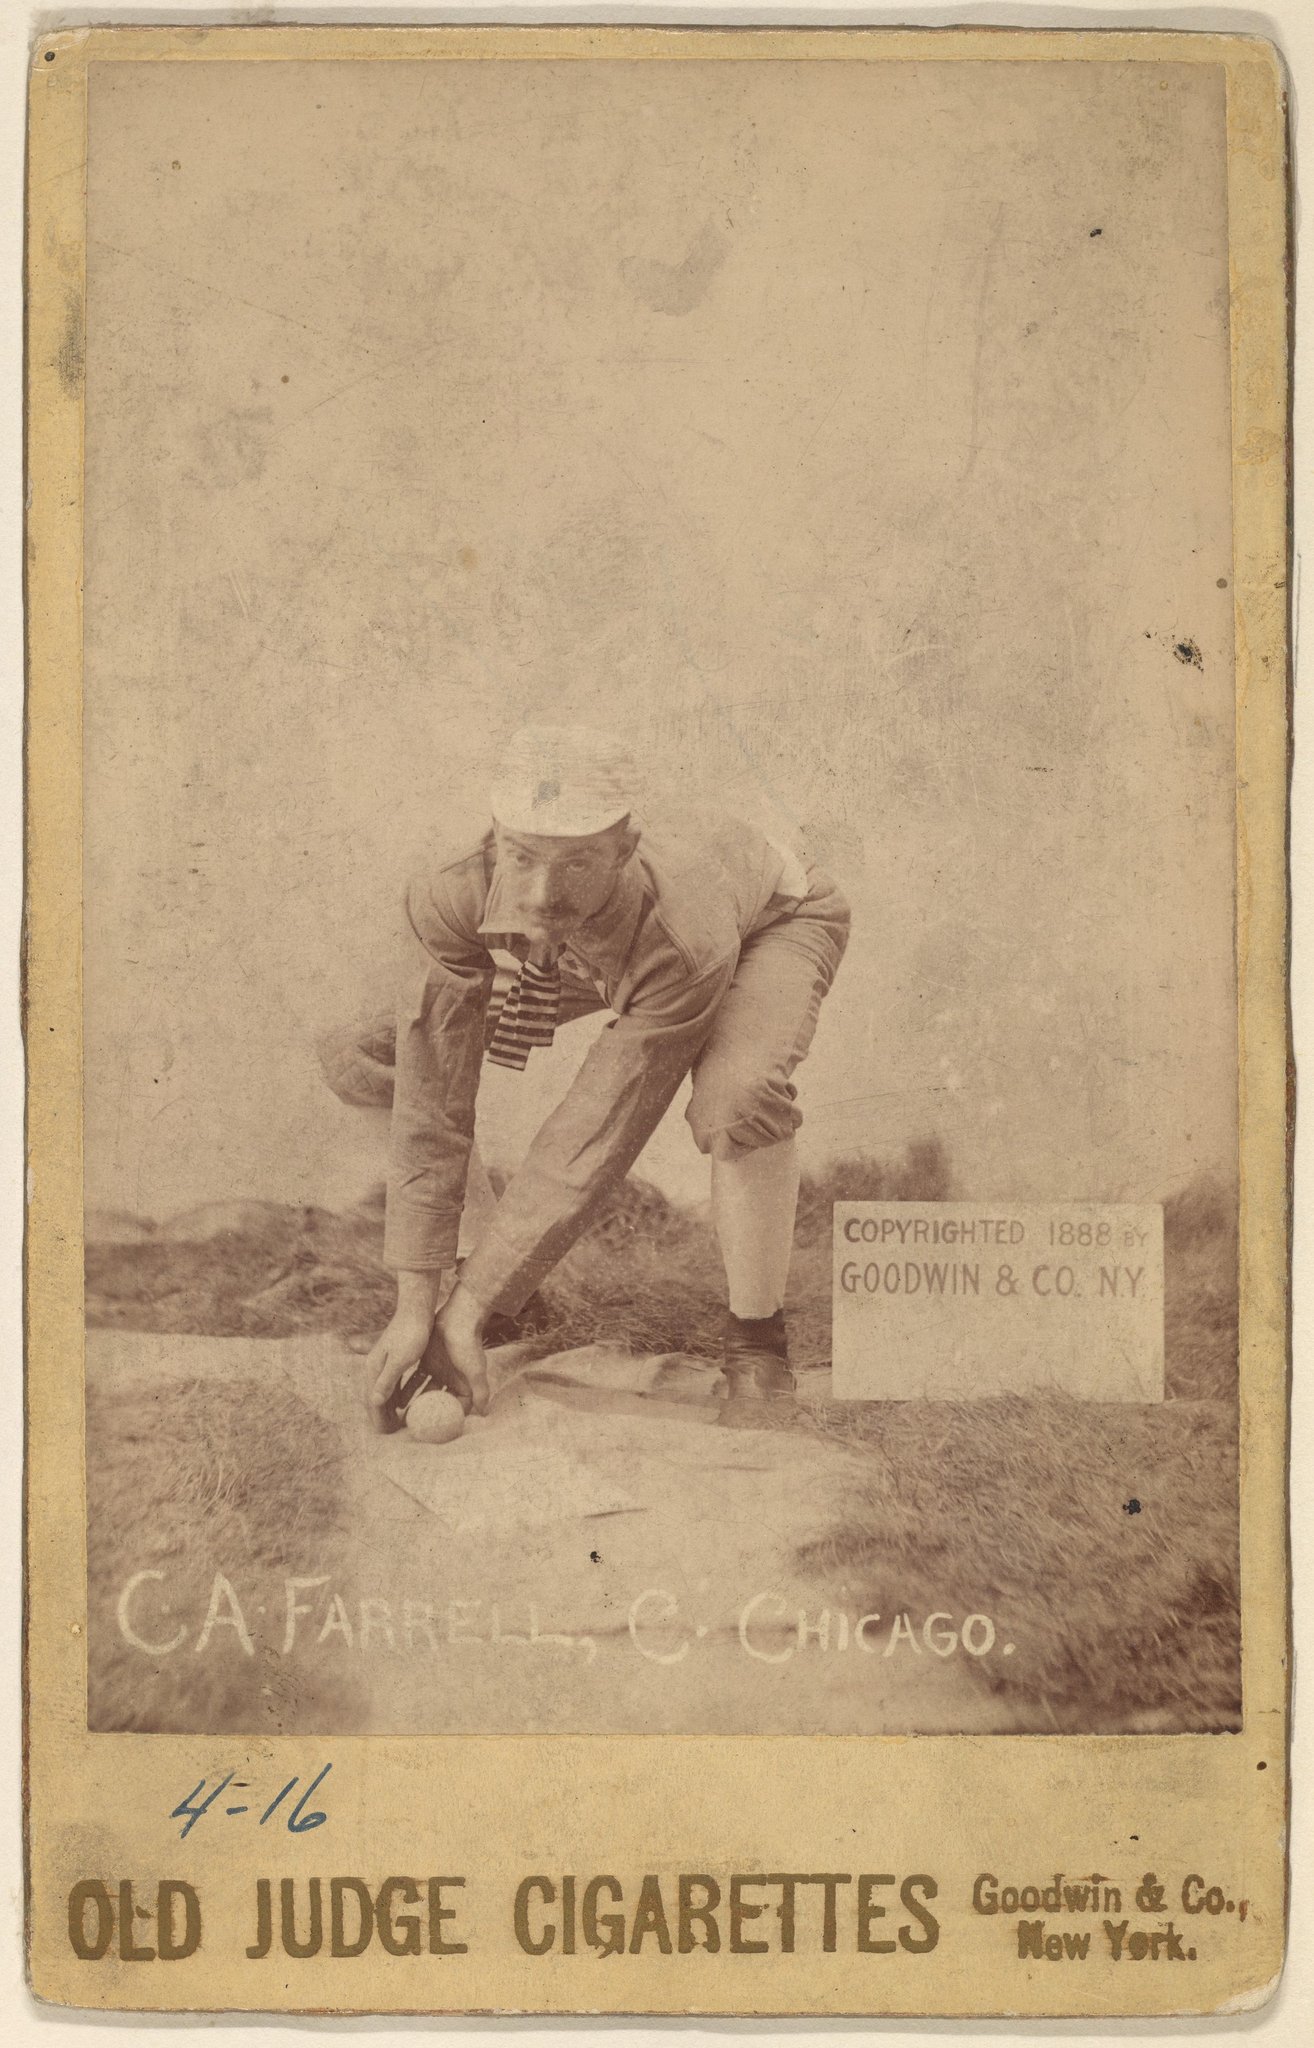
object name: baseball card, photograph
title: Charles Andrew Farrell, Catcher, Chicago, from the series Old Judge Cigarettes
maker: goodwin & company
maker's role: publisher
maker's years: 1850-1950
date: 1888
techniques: albumen silver print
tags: men,portraits,baseball,athletes